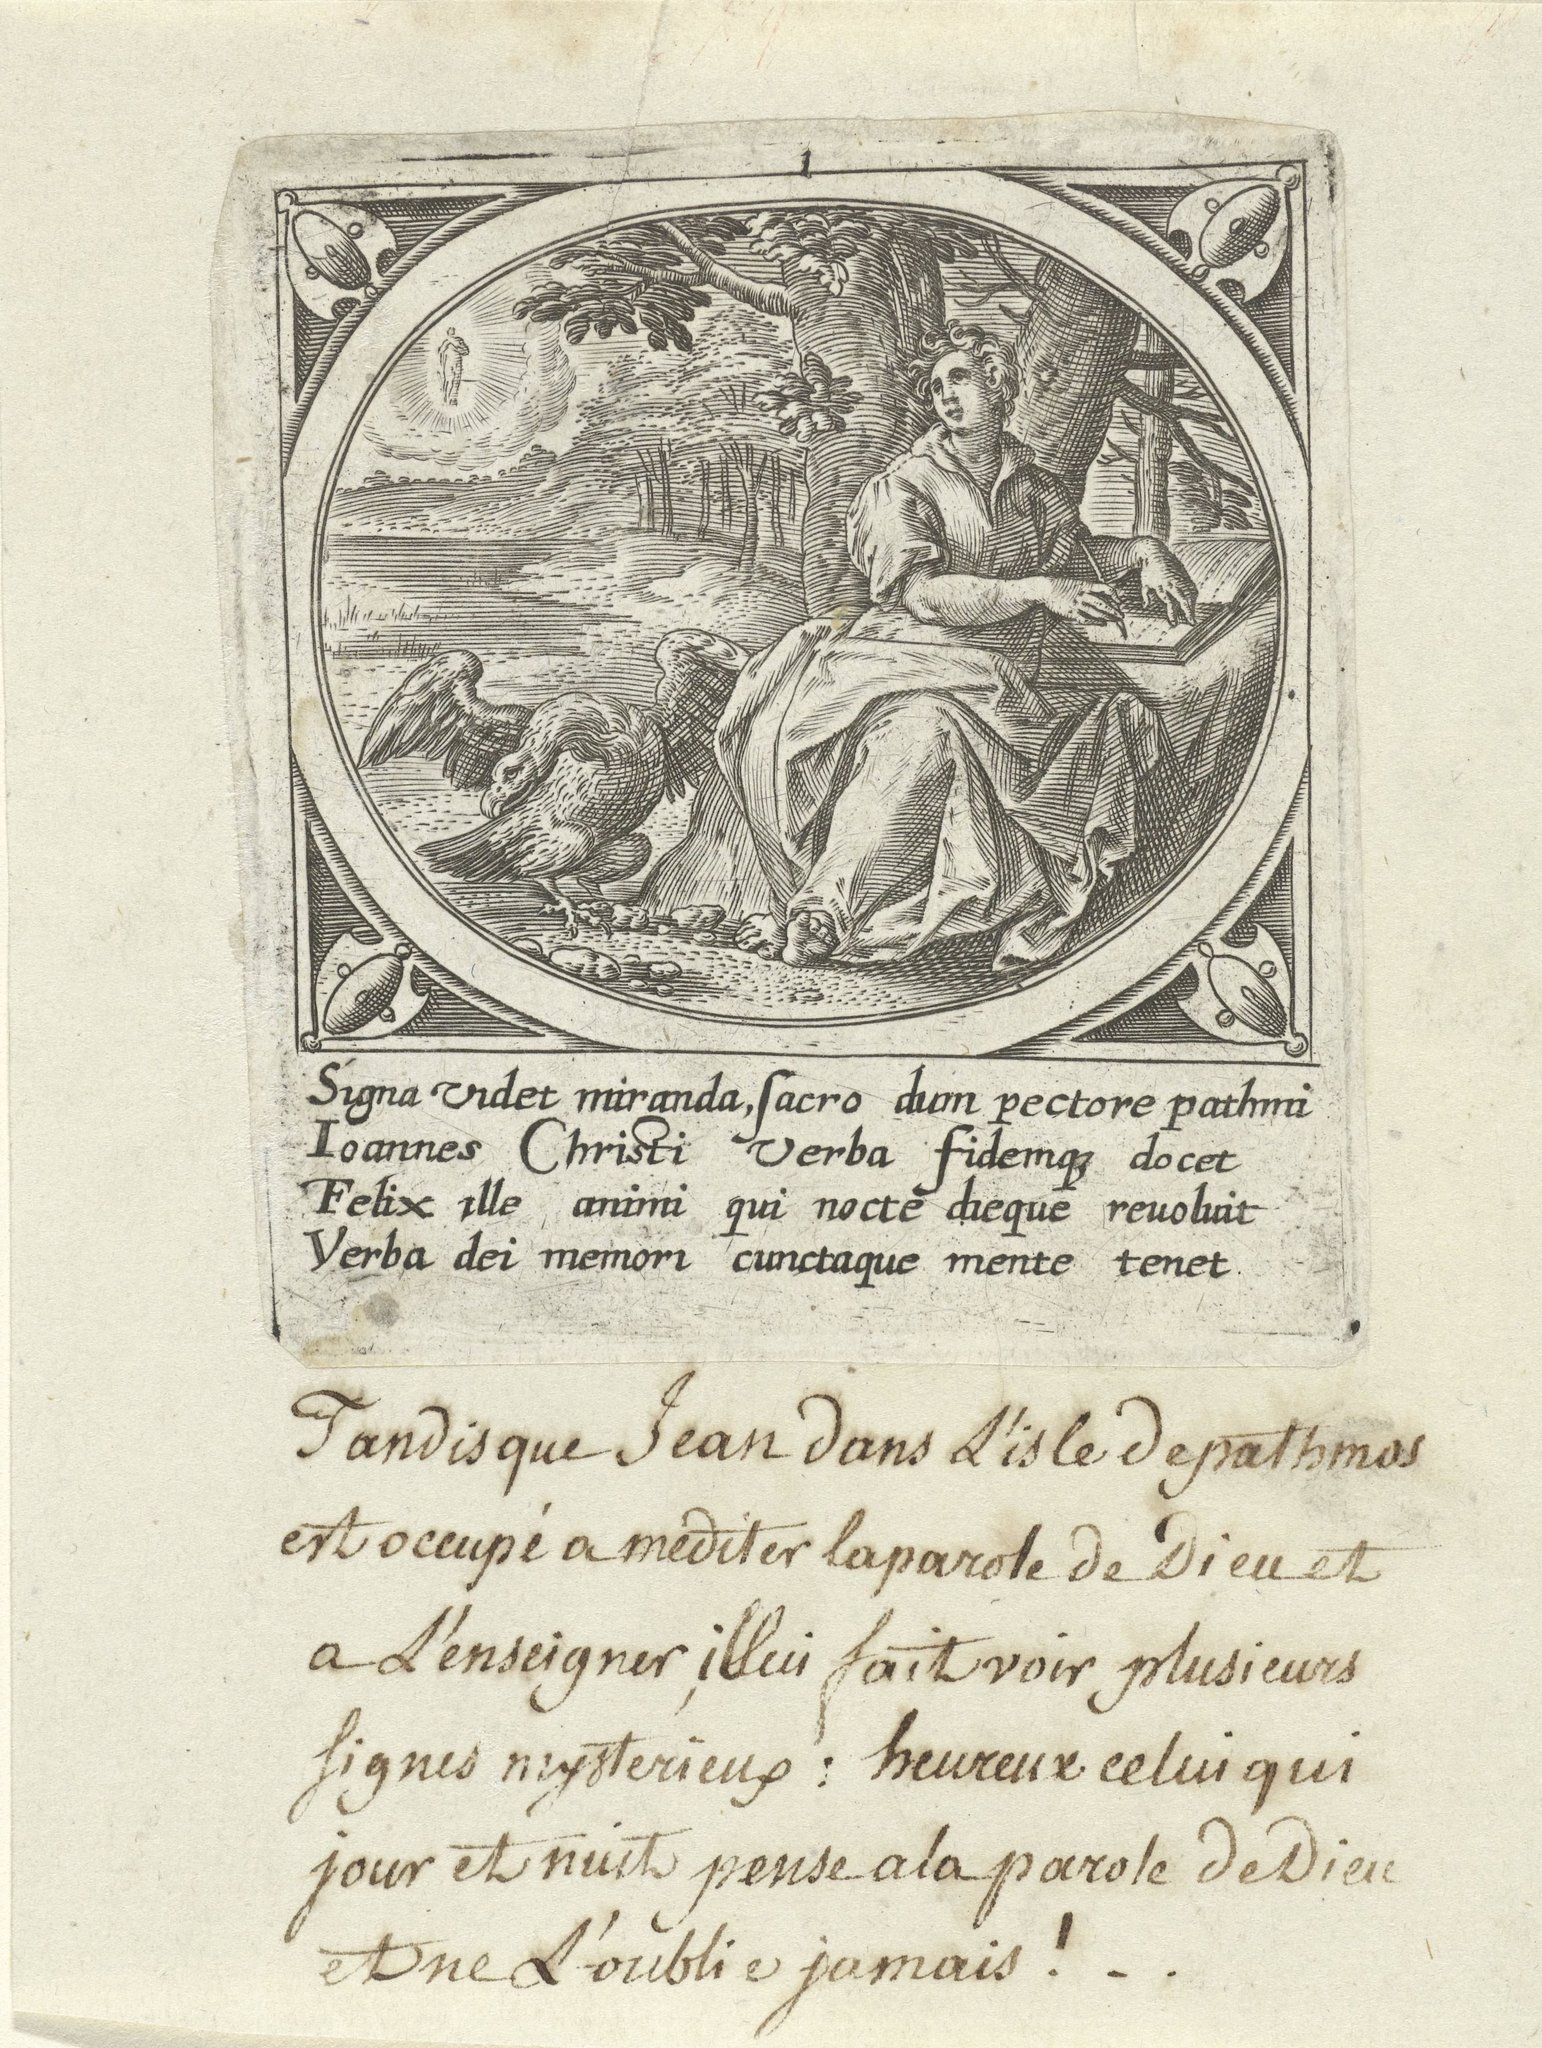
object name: print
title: Johannes op Patmos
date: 1585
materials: paper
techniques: engraving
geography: antwerp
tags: john (writing) on the island of patmos, possibly the eagle beside him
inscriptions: inscription: ‘Tandisque Jean dans l'isle de pathmos [...] oubli jamais!’, collector's mark: Lugt 2228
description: Landschap met de apostel en evangelist Johannes, met de adelaar, zijn symbool. Johannes schrijft in een boek en kijkt naar een verschijning in de lucht. In de marge een vierregelig onderschrift in het Latijn. Eerste prent uit een serie van vierentwintig met de openbaring van Johannes op Patmos.